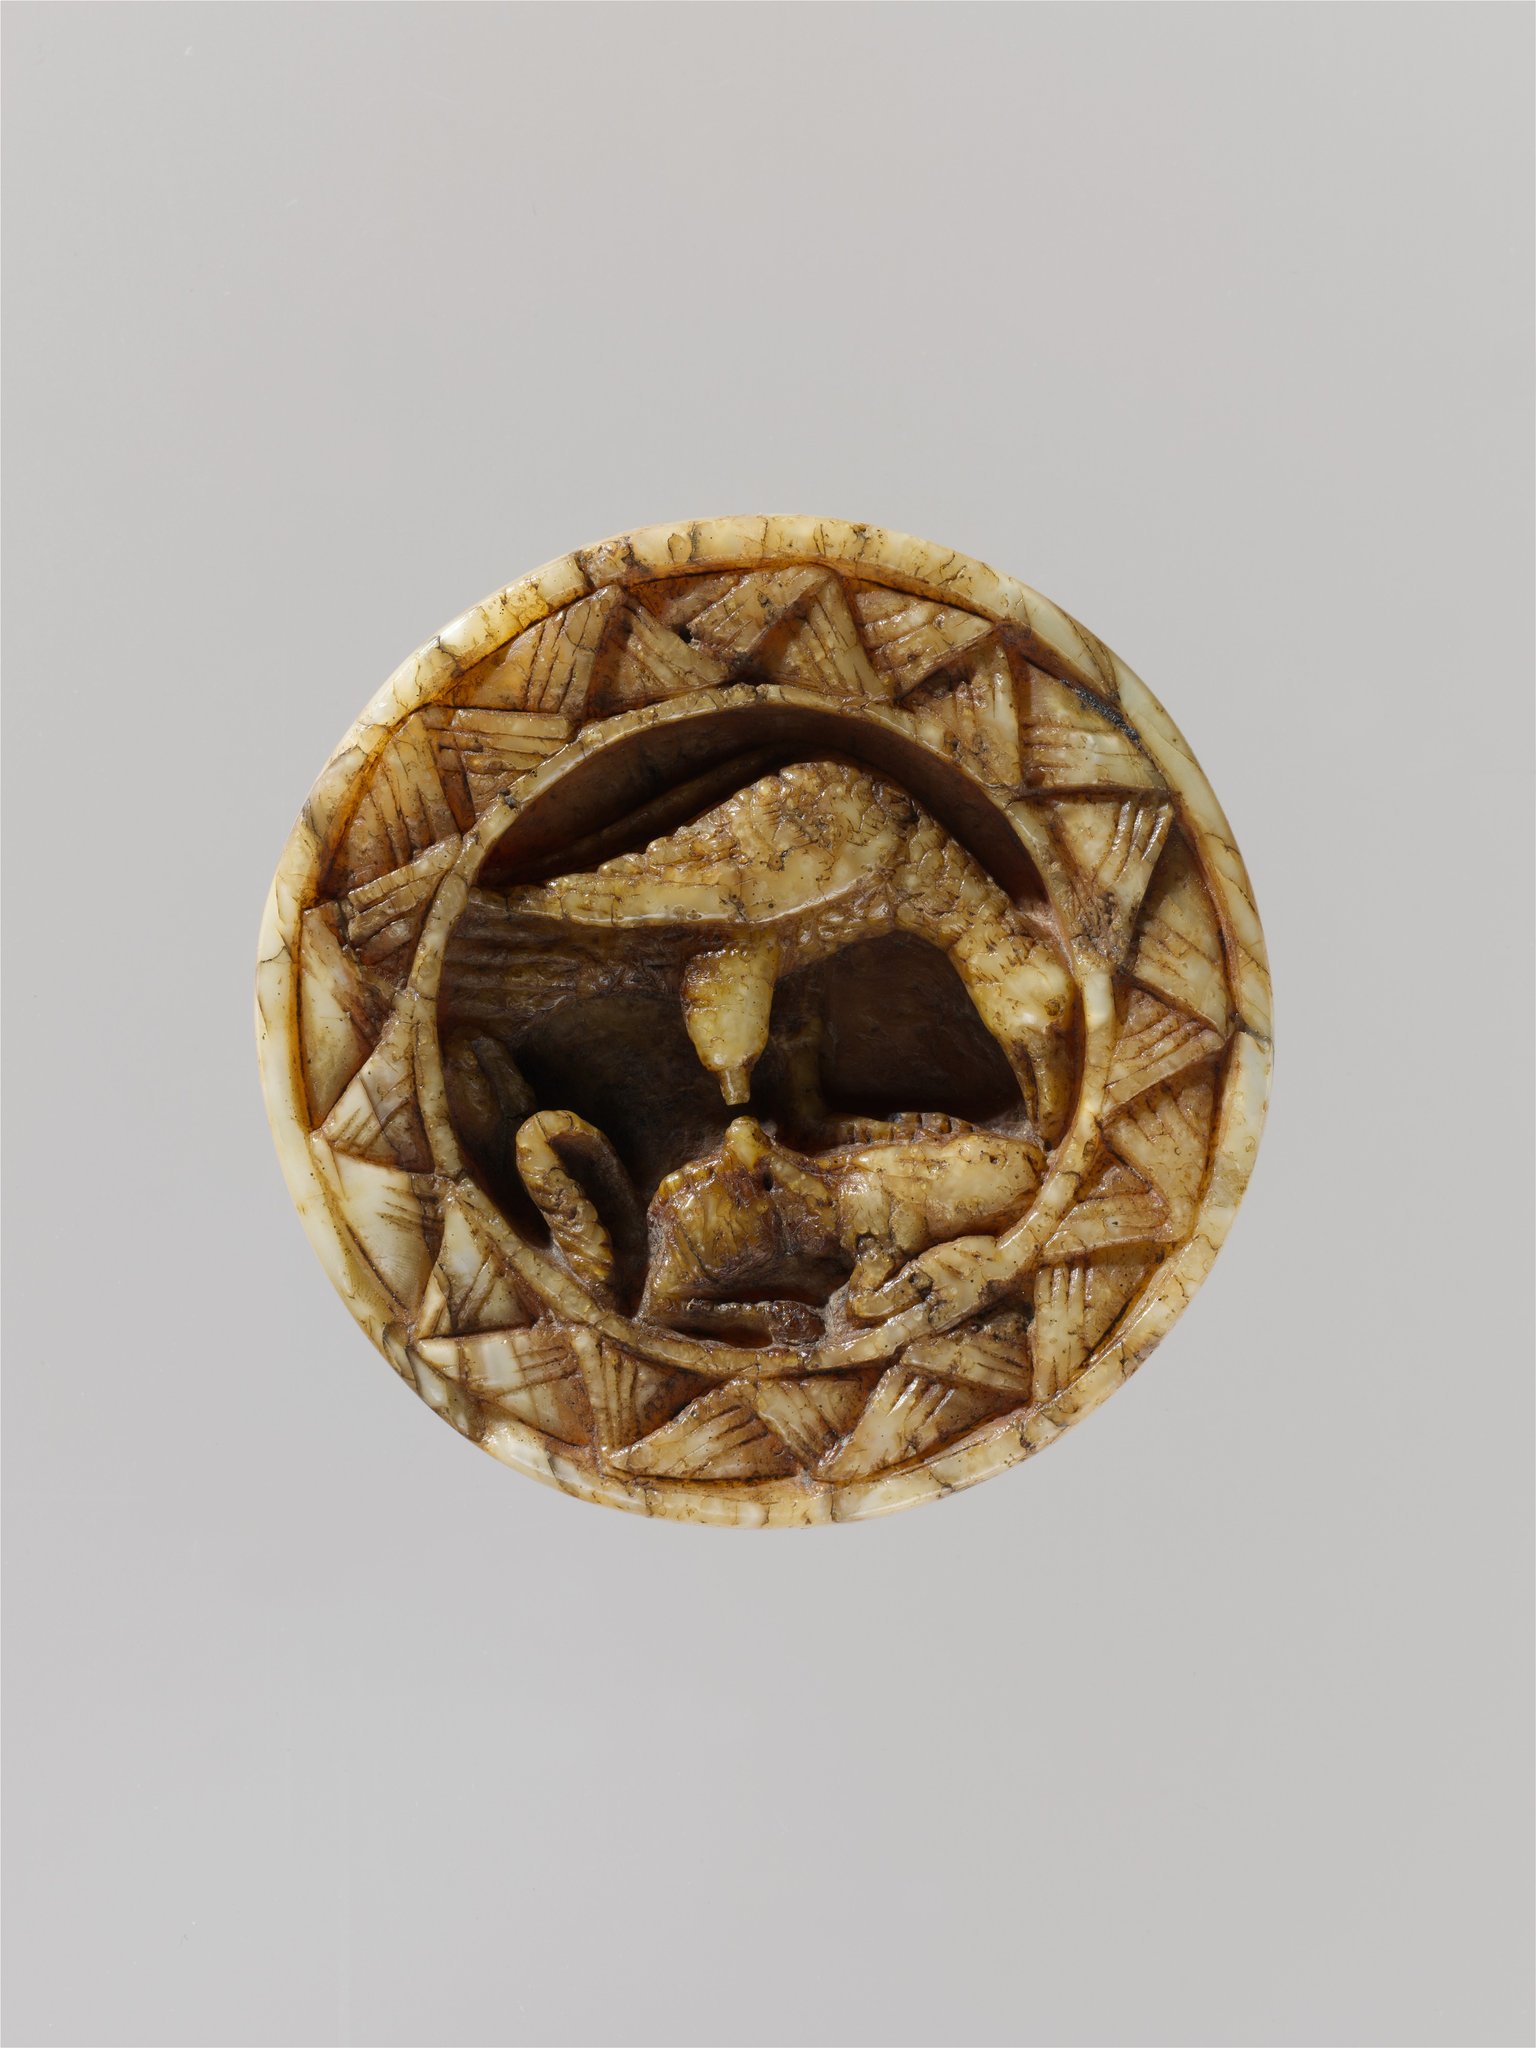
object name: game piece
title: Game Piece with an Eagle Attacking a Hare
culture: german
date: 1100-1200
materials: ivory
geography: germany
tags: eagles,rabbits,games